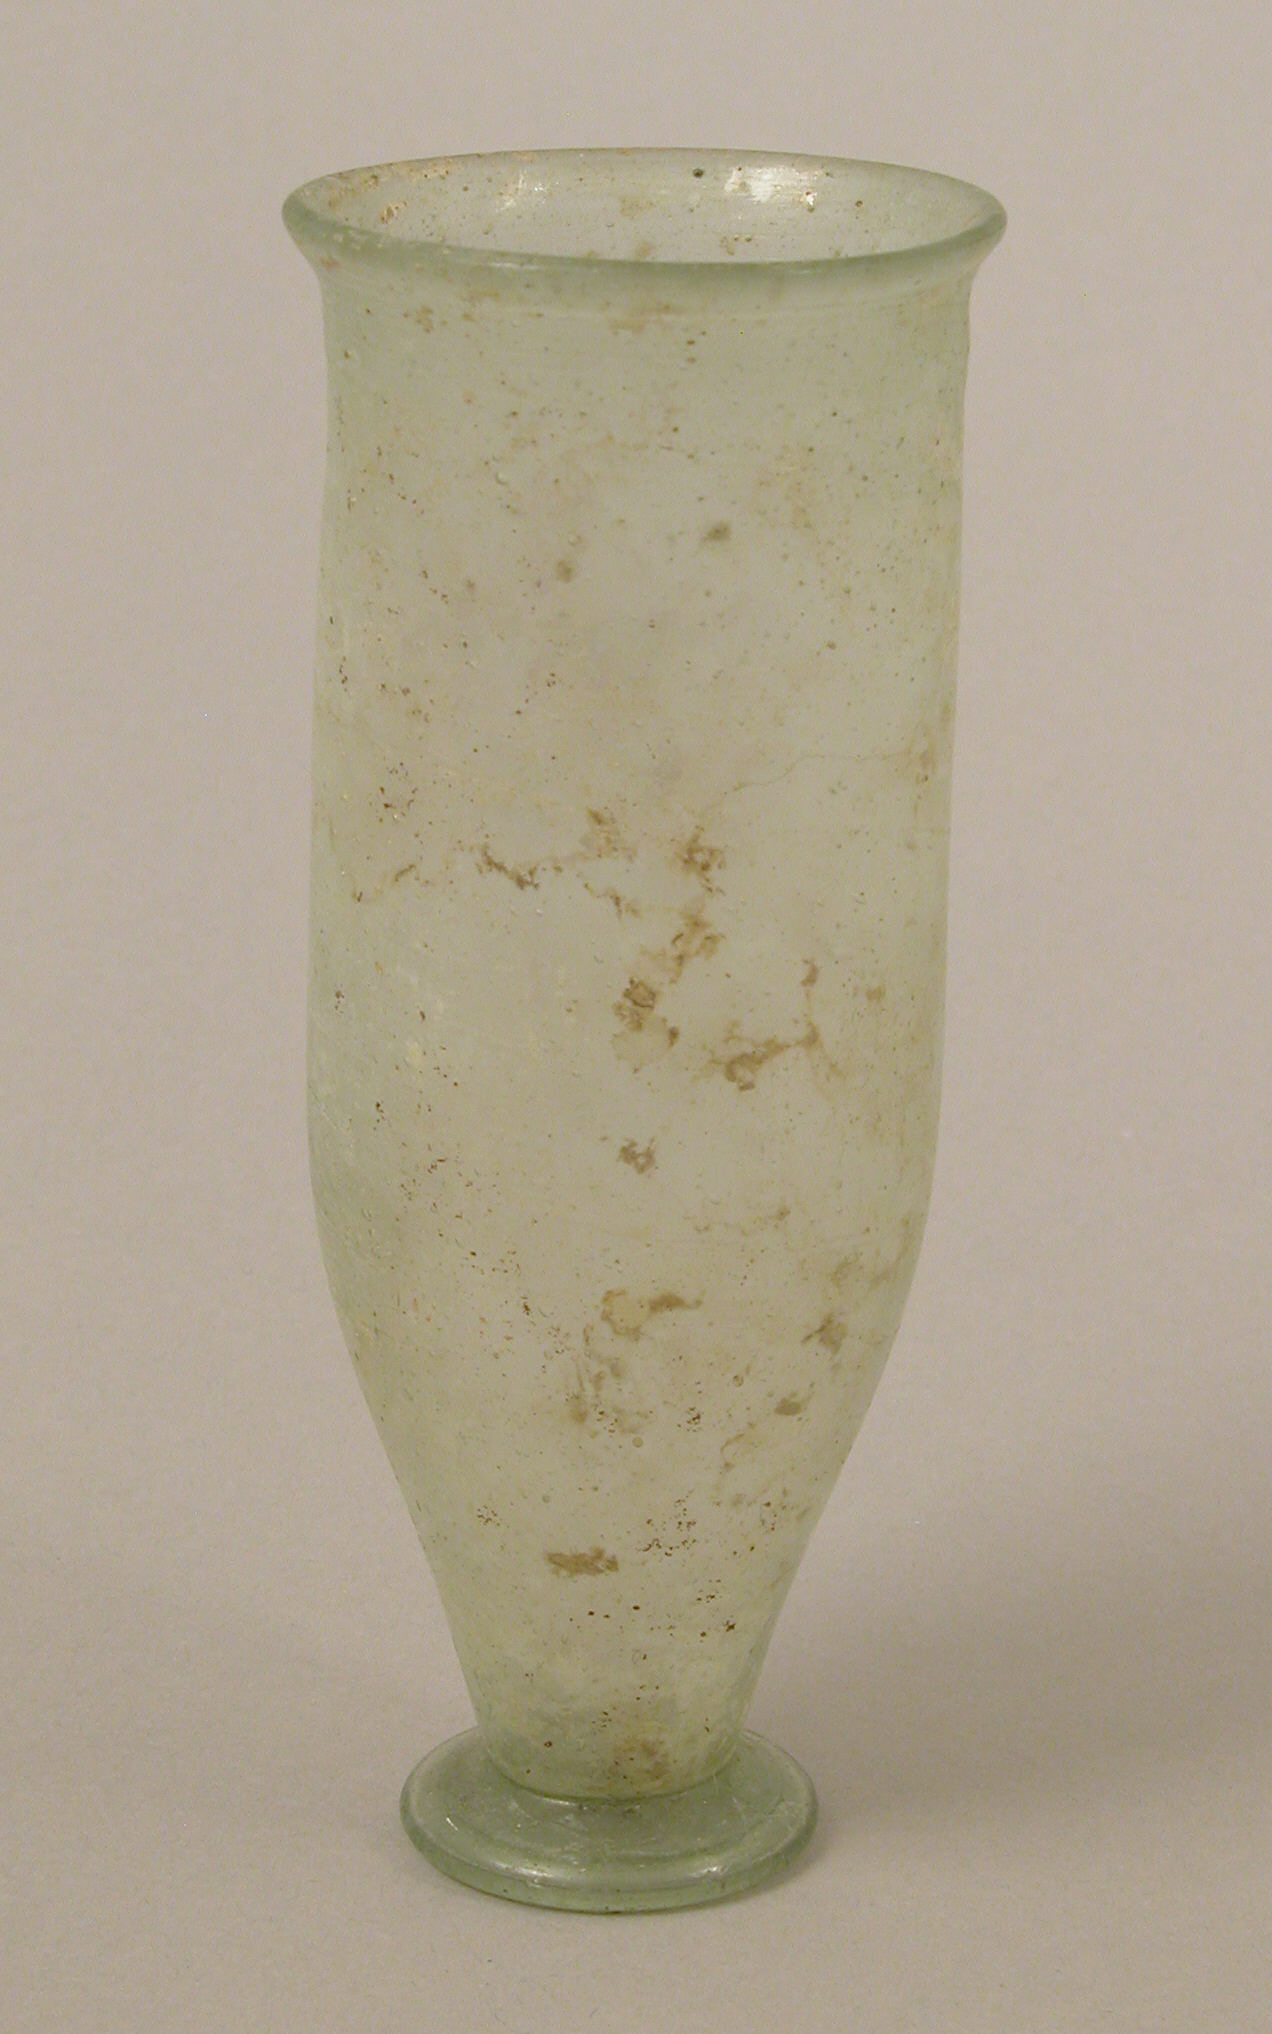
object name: beaker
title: Footed Glass Beaker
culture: frankish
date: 375-425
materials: glass